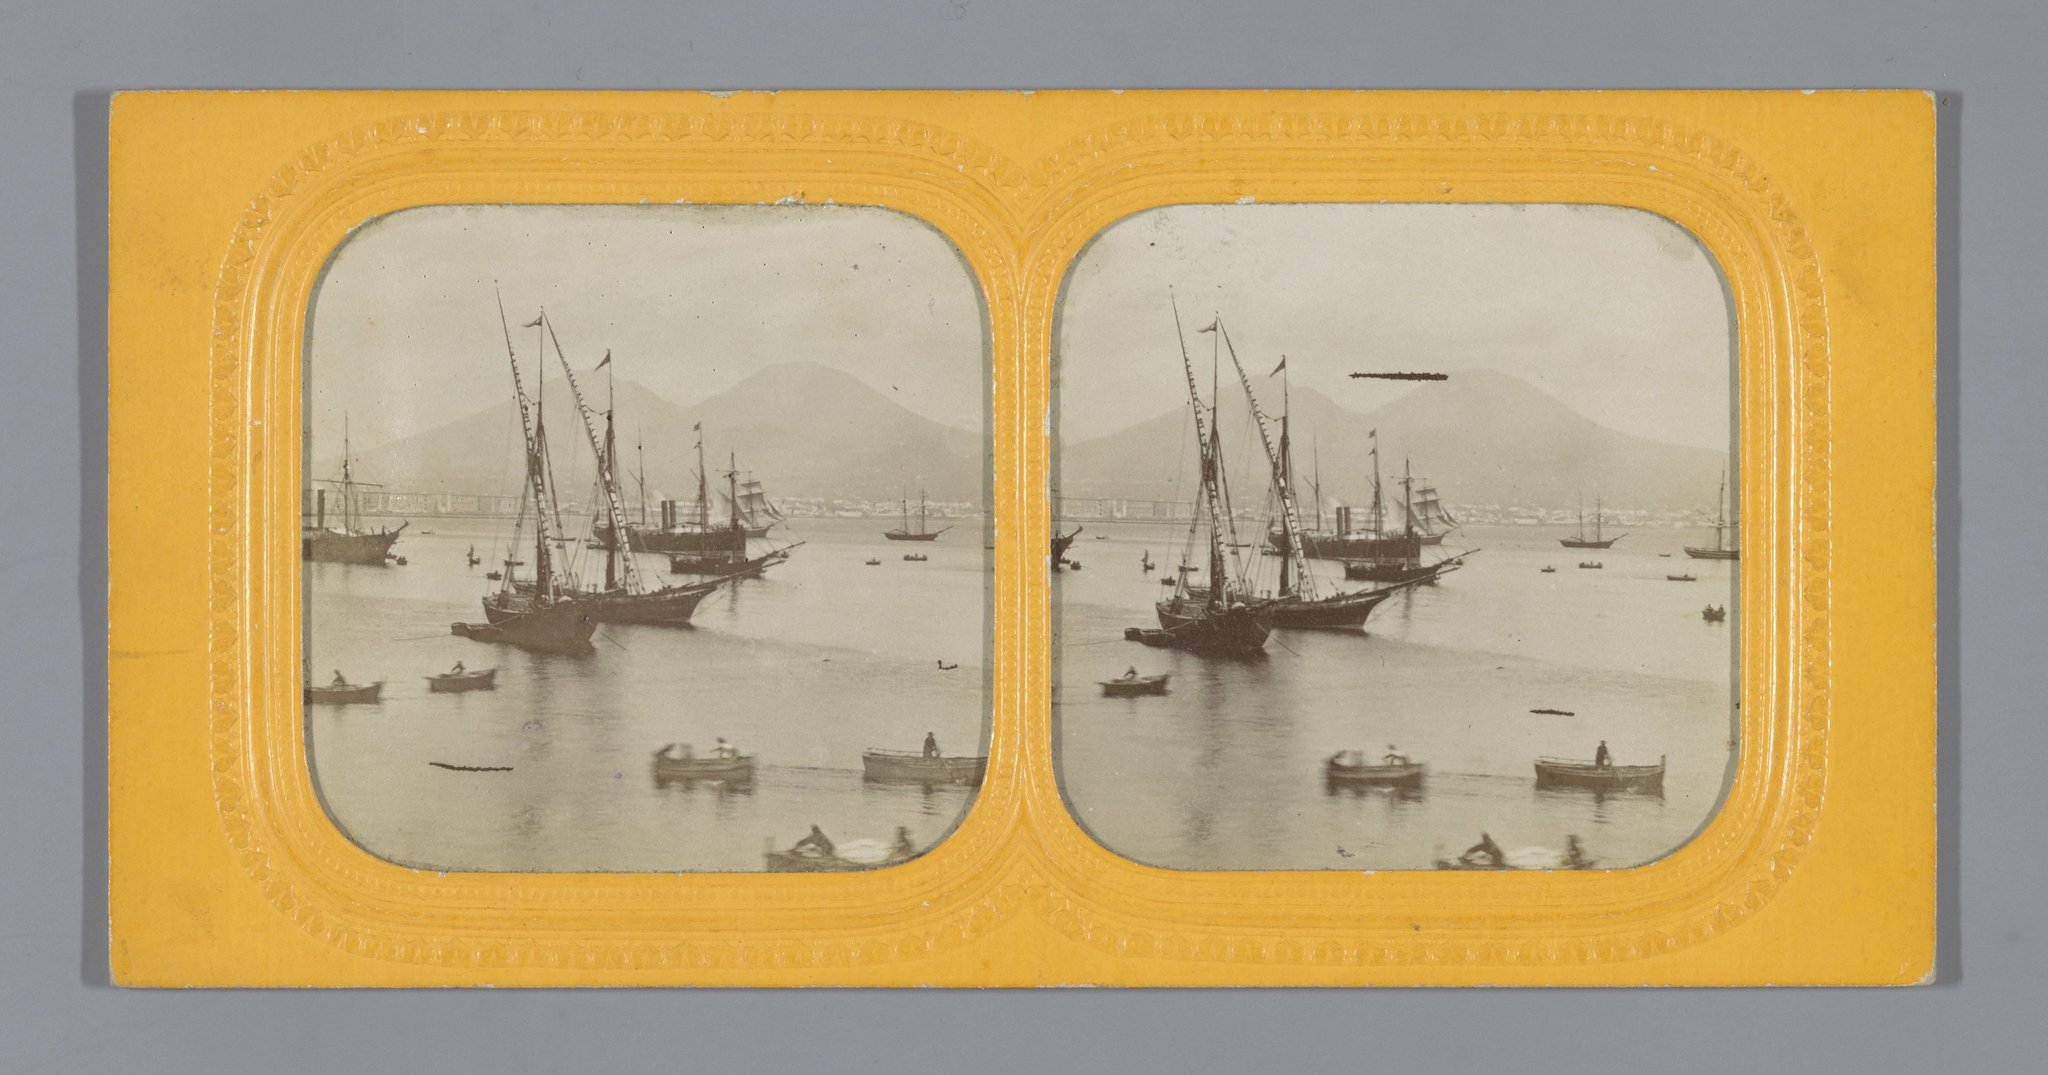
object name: tissue stereograph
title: Naples, Italië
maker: Anonymous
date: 1855-1875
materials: cardboard, paper, photographic support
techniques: albumen print, hand coloring, perforating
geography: naples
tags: sailing-ship, sailing-boat, lake, mountains, naples